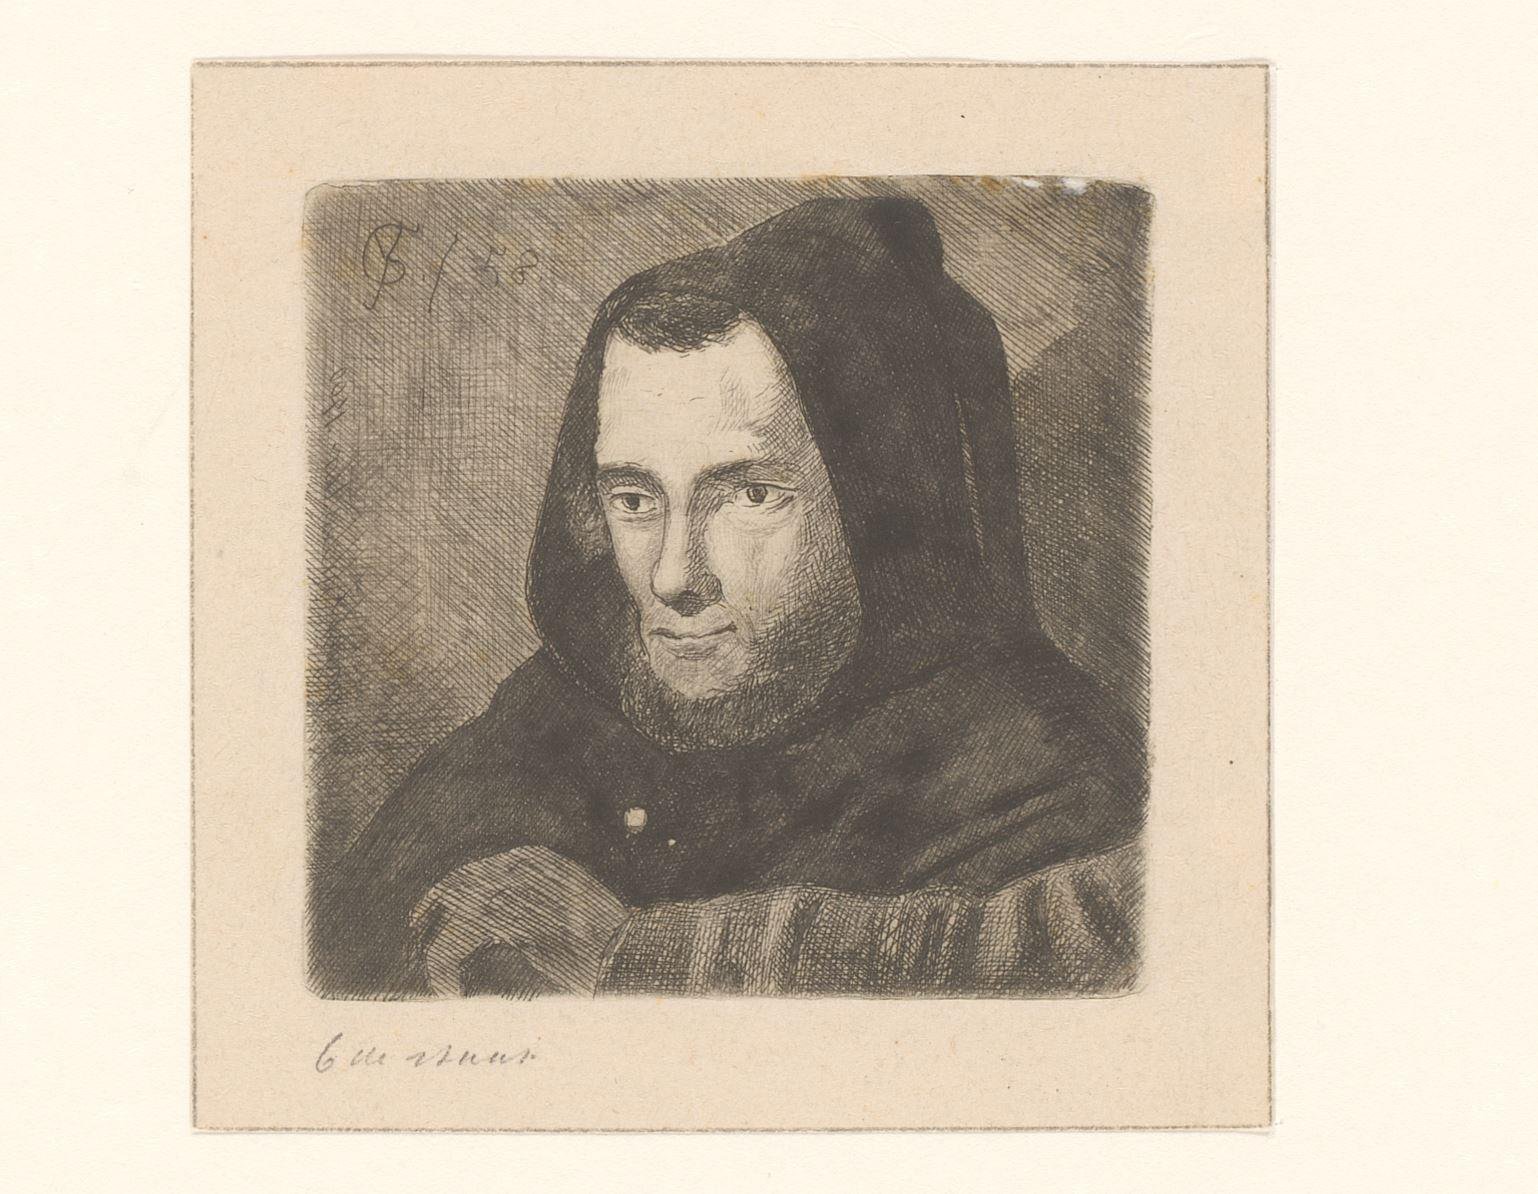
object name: print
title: Buste van een monnik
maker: cornelis van der griendt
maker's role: draughtsman, painter, print maker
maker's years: 1827-1918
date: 1864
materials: paper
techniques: etching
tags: monk(s), friar(s)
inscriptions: annotation: ‘6de staat’, collector's mark: Lugt 2228